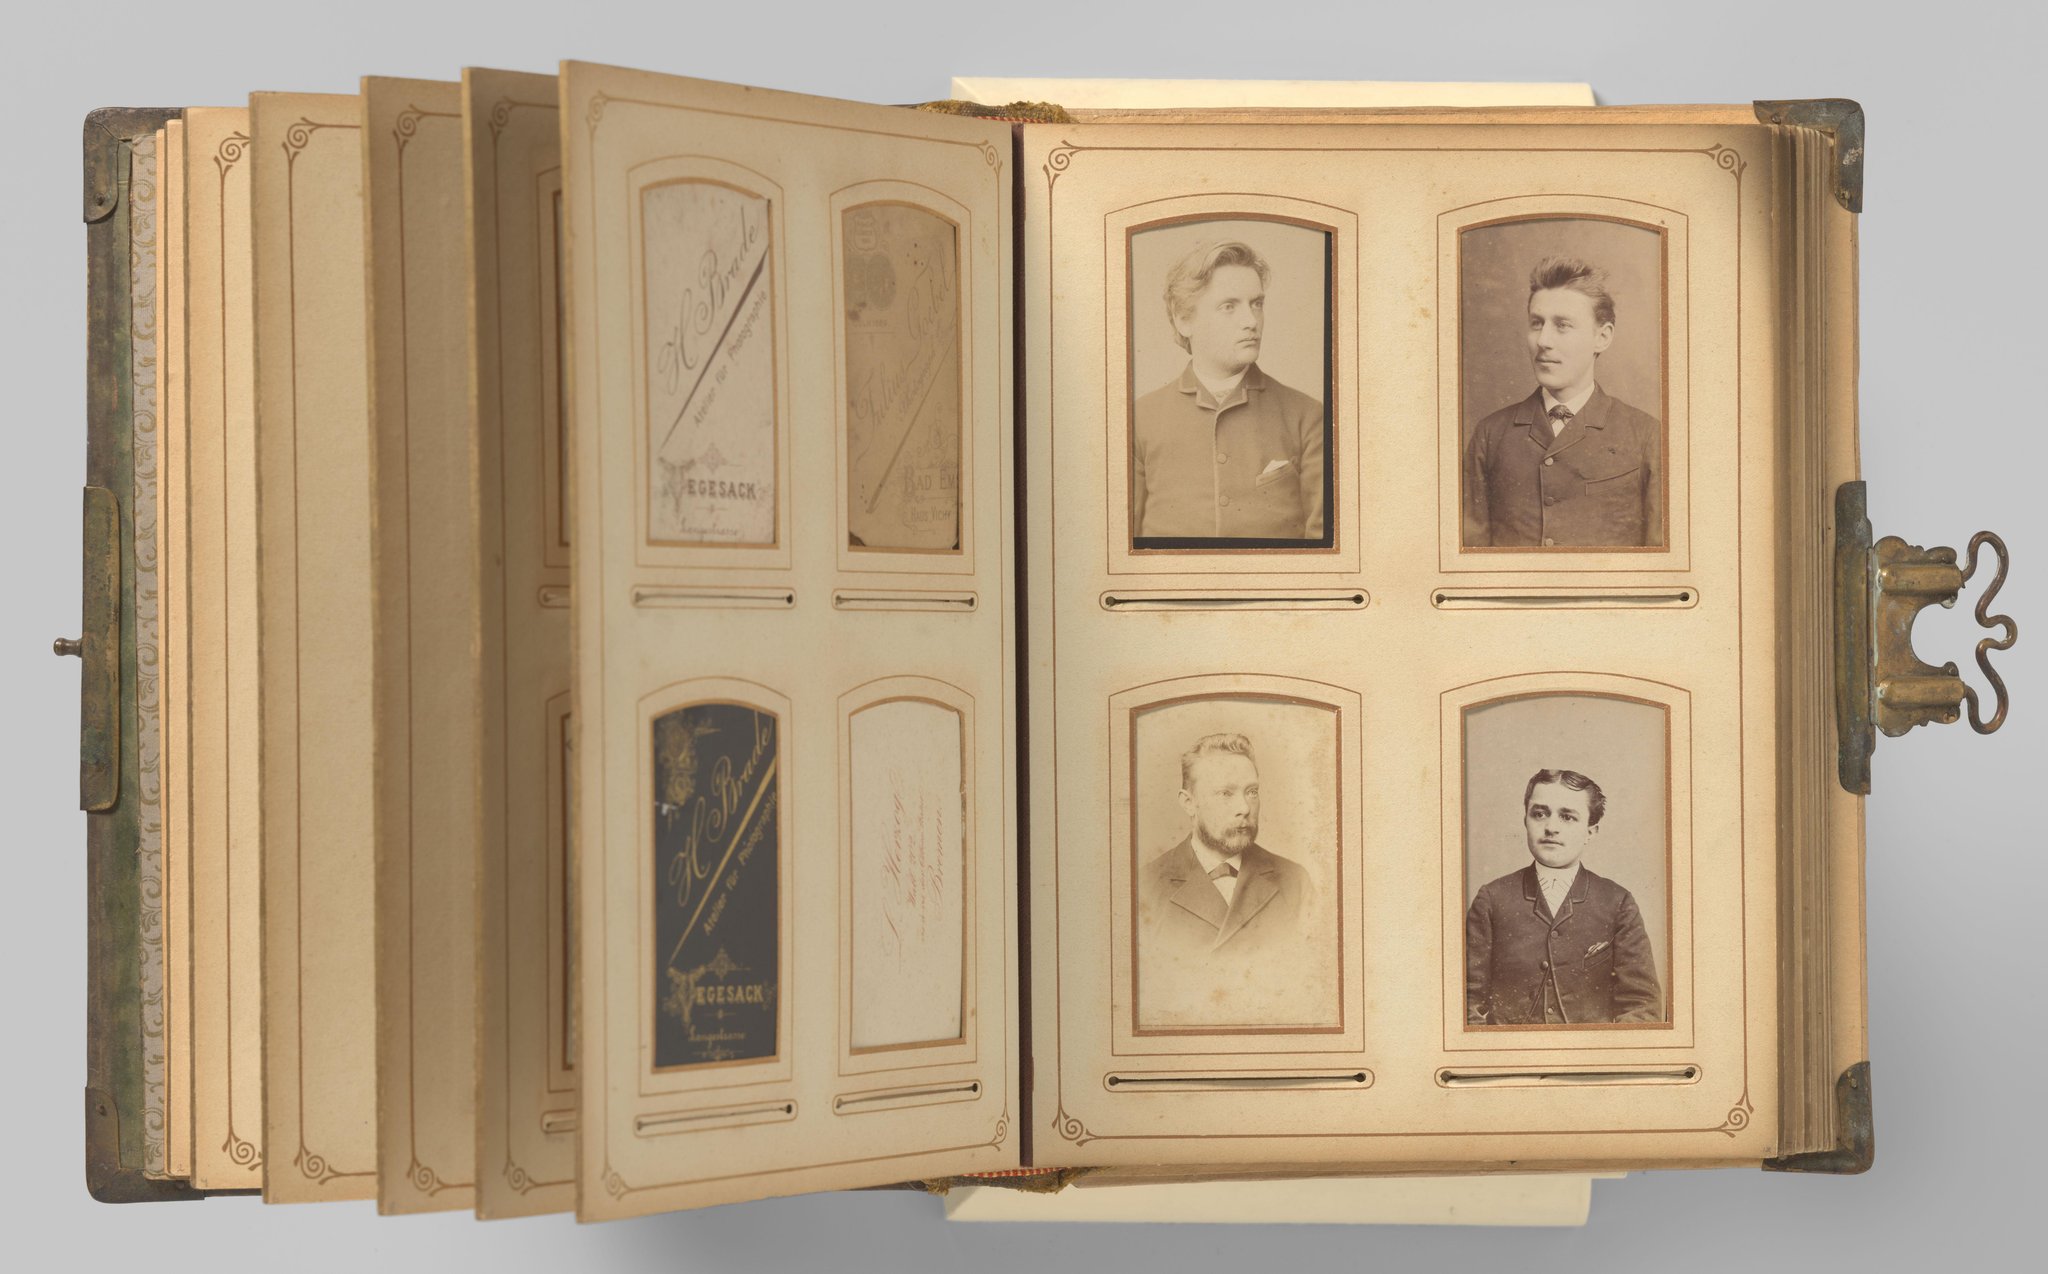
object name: photograph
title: Portret van een jonge man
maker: Anonymous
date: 1880-1920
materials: cardboard, photographic support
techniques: collodion silver print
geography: germany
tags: historical persons, youth, adolescent